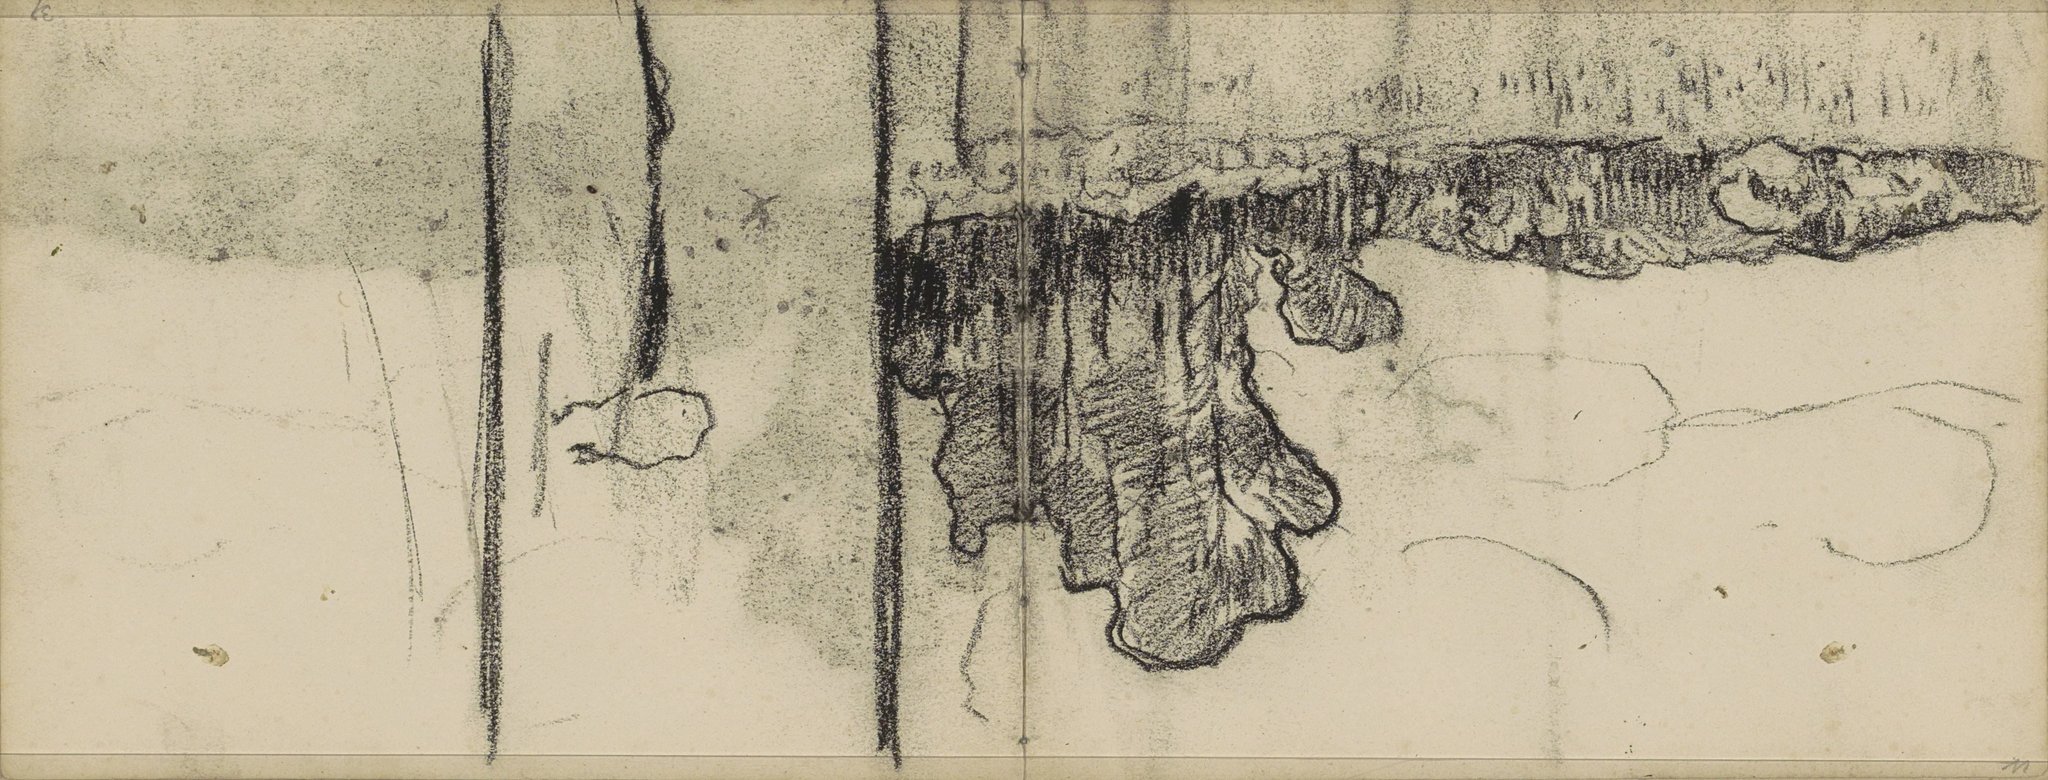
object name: sketchbook leaf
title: Landschap met bomengroep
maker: hermannus adrianus van oosterzee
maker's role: draughtsman, painter, print maker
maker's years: 1863-1933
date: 1893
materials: charcoal, paper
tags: trees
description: Blad 10 verso en 11 recto uit een schetsboek met 23 bladen.